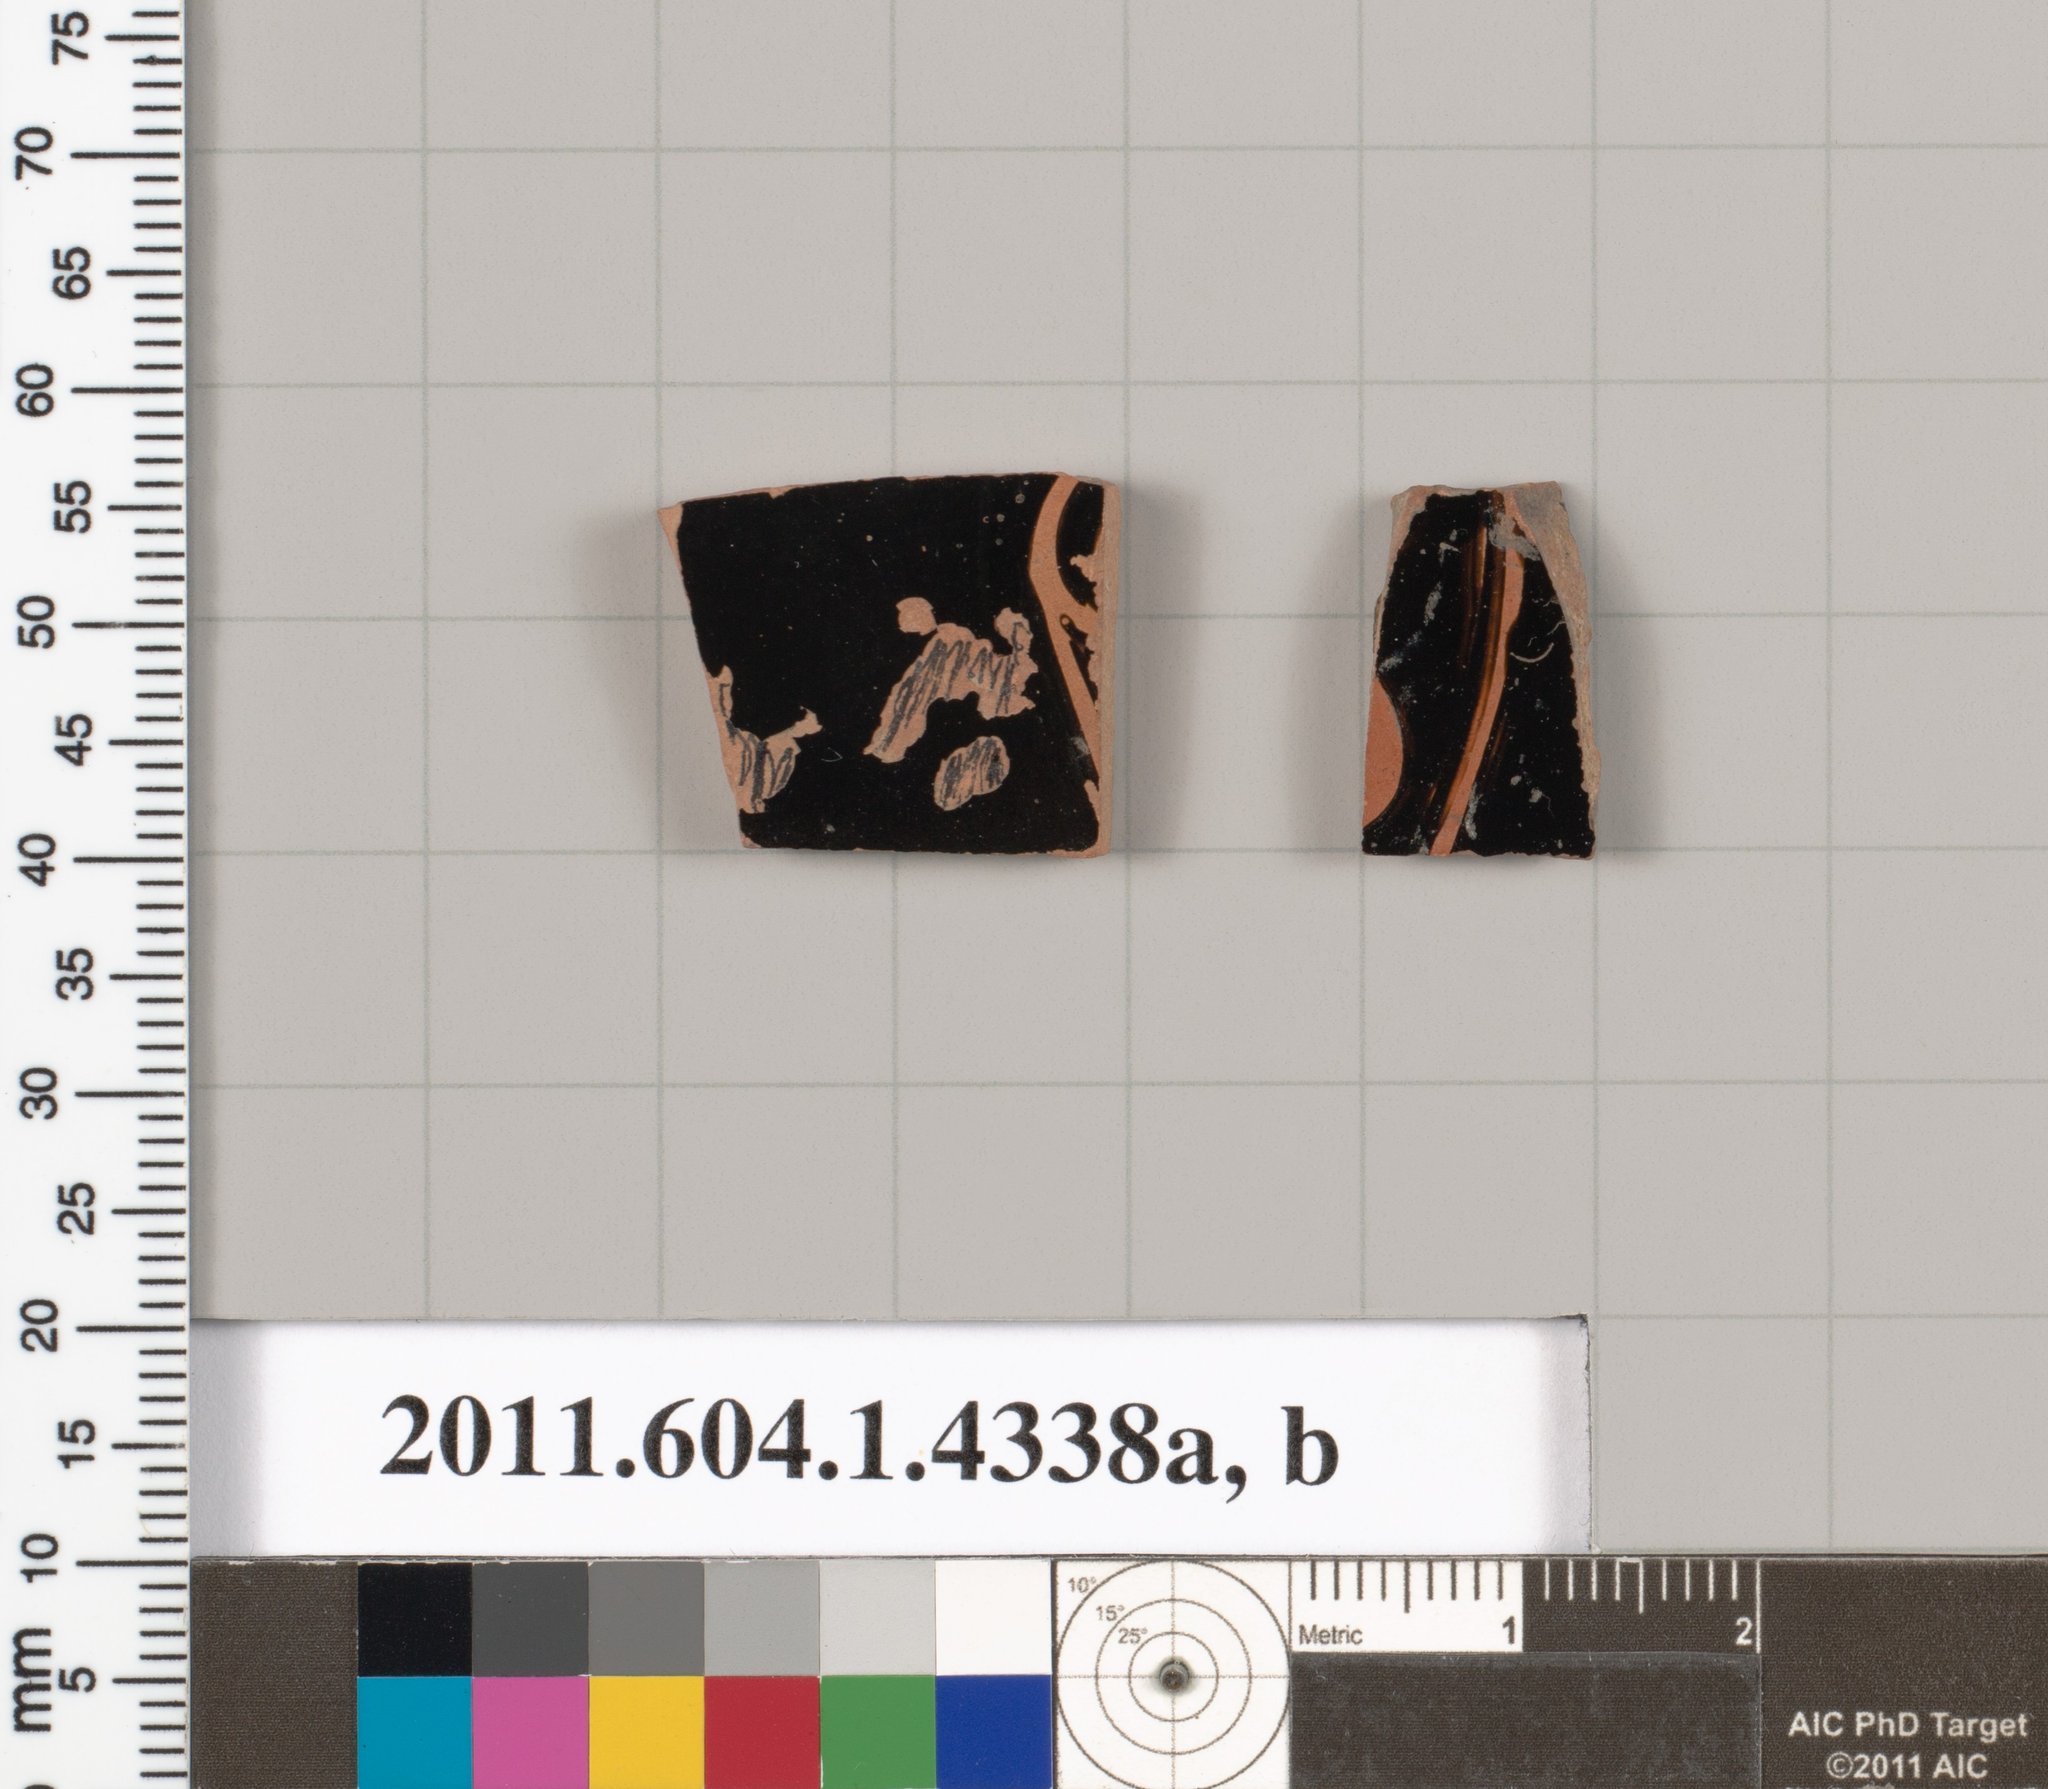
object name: kylix fragment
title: Terracotta fragments of kylikes (drinking cups)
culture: greek, attic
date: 500-451 BCE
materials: terracotta